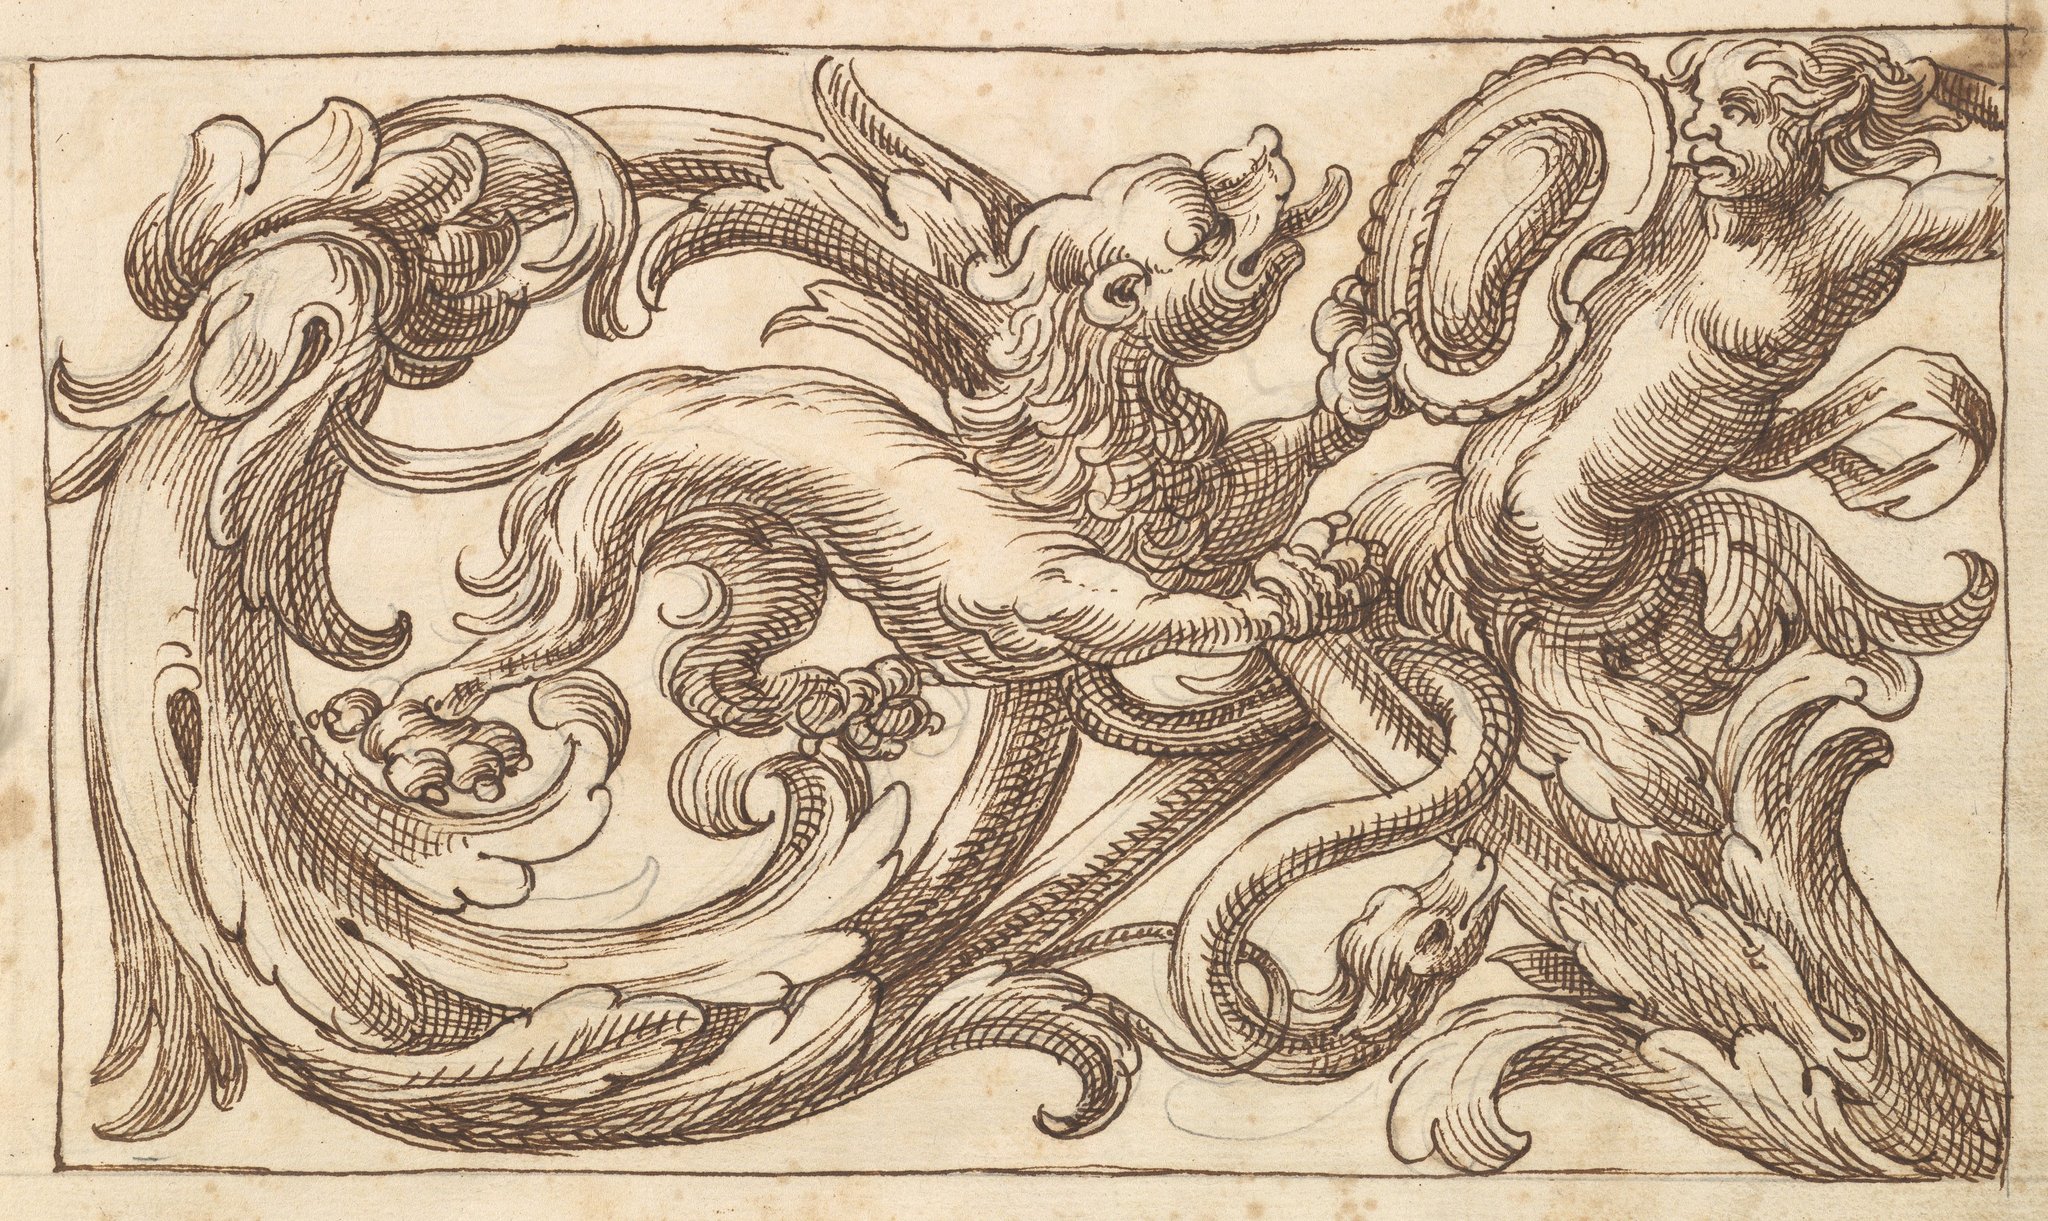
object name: collection ornament architecture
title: Horizontal Panel Design with a Male Figure and a Lion Interspersed between Acanthus Rinceaux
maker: anonymous, italian, venetian, 17th century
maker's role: artist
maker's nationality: italian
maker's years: 1600-1700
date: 1601-1700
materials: ink, drawing material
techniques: pen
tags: men,lions